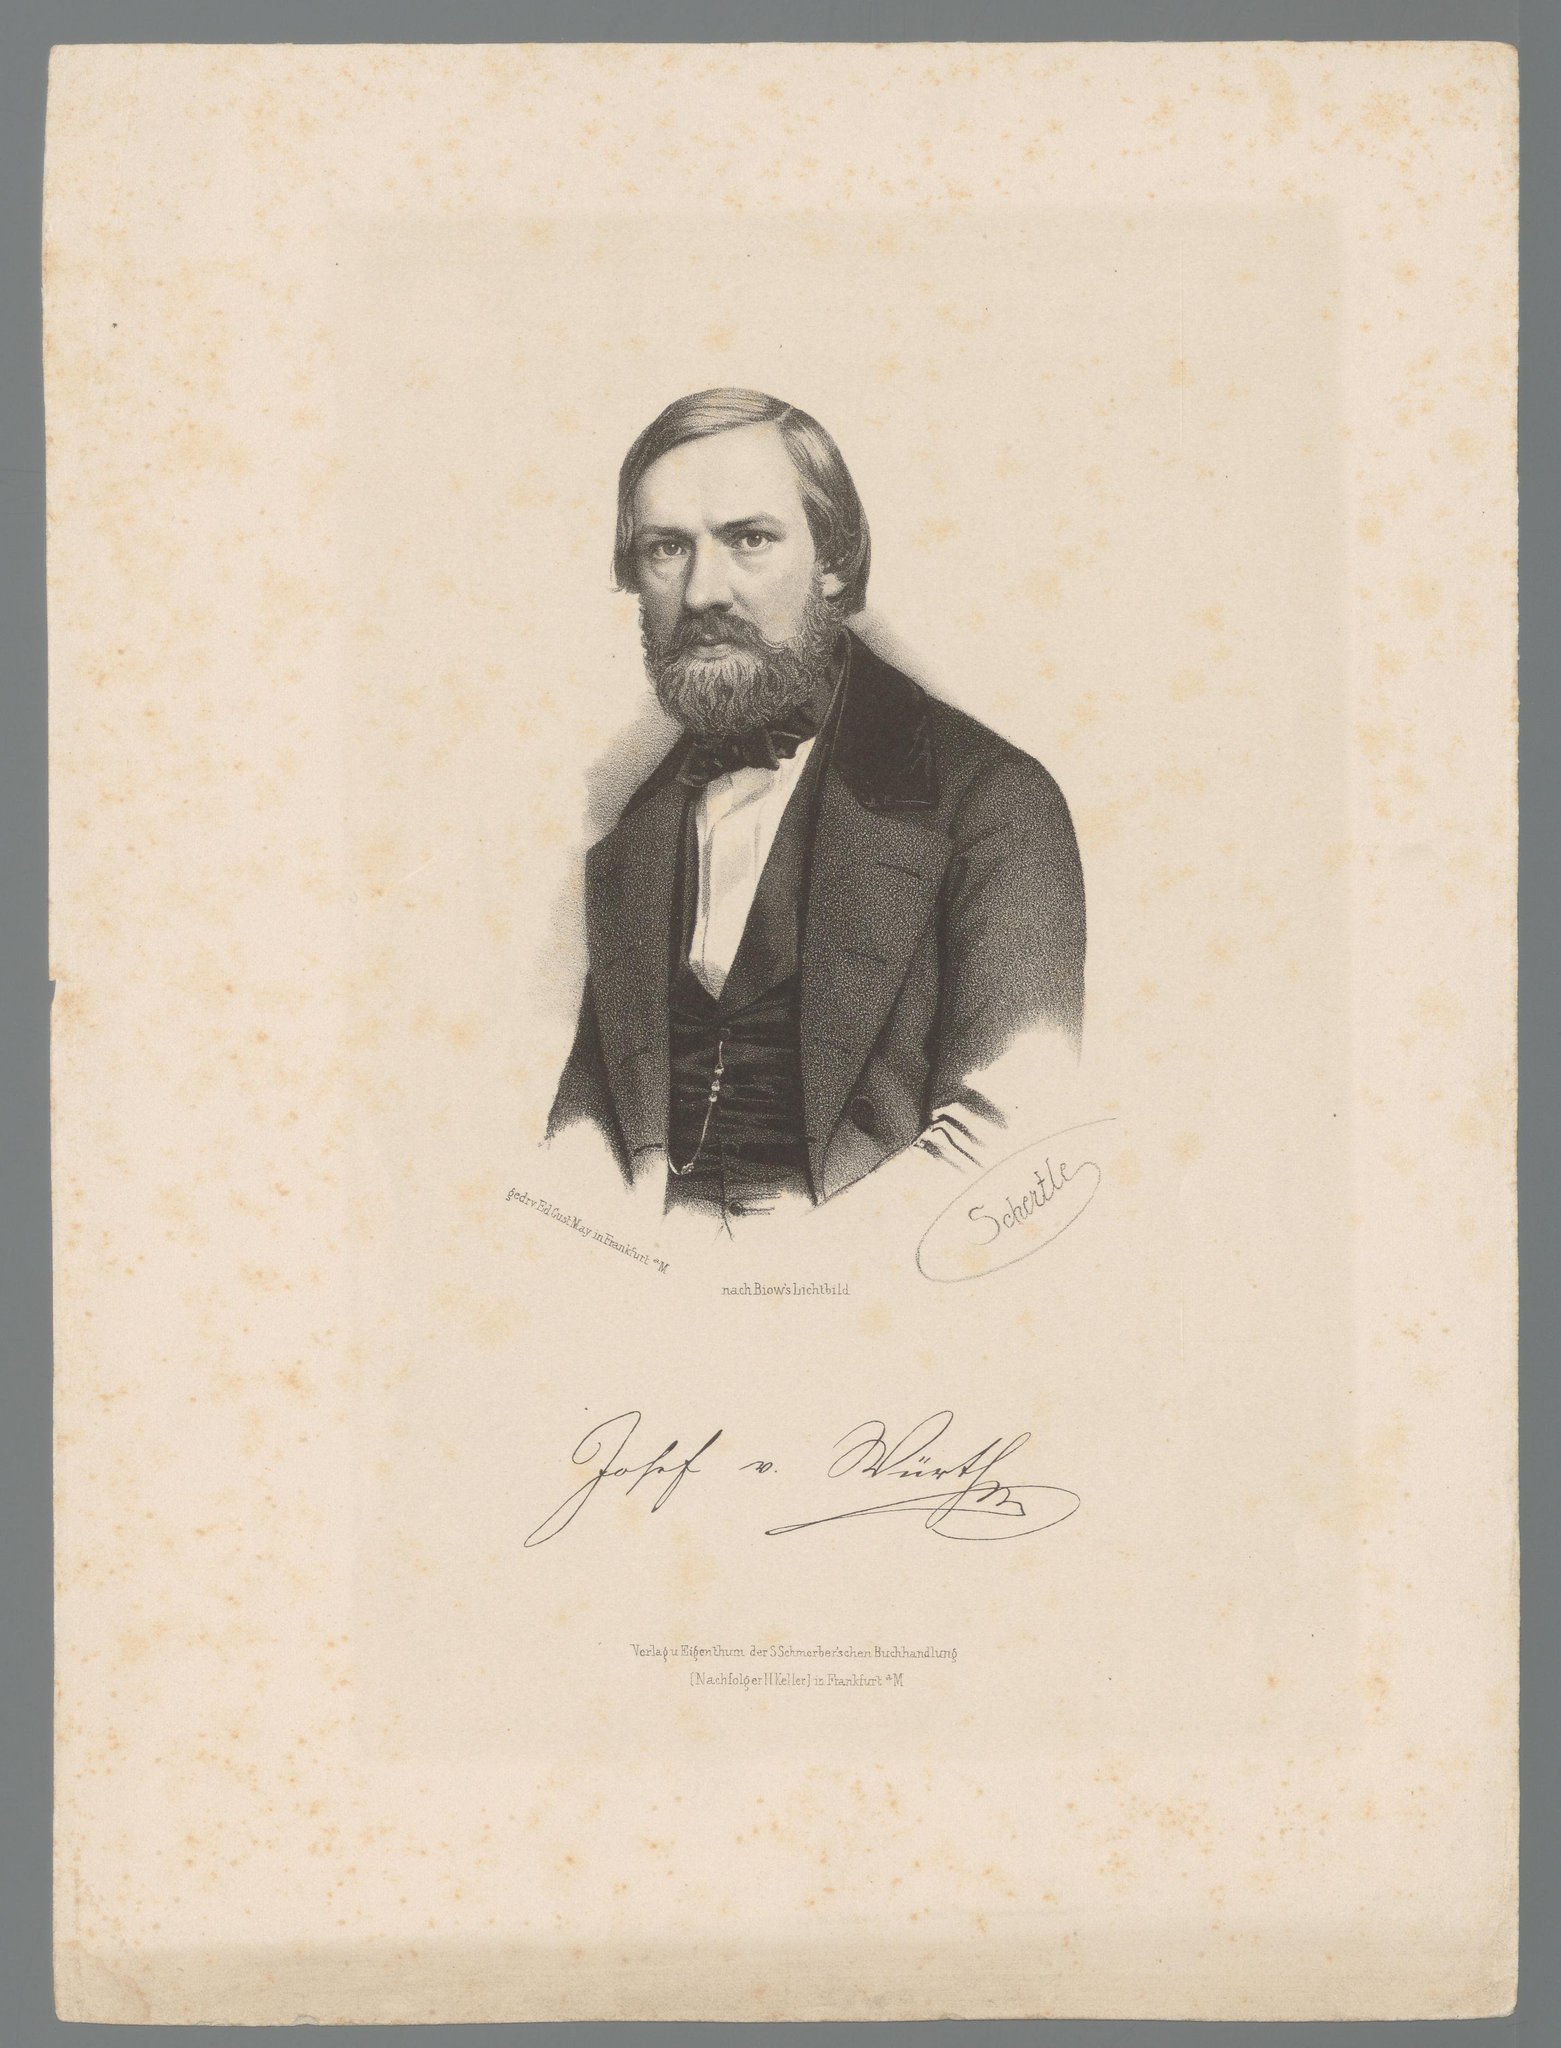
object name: print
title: Portretten van Duitse mannen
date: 1848-1849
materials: paper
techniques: lithograph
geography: frankfurt am main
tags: vienna, adult man, historical persons, beard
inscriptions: collector's mark: Lugt 2228